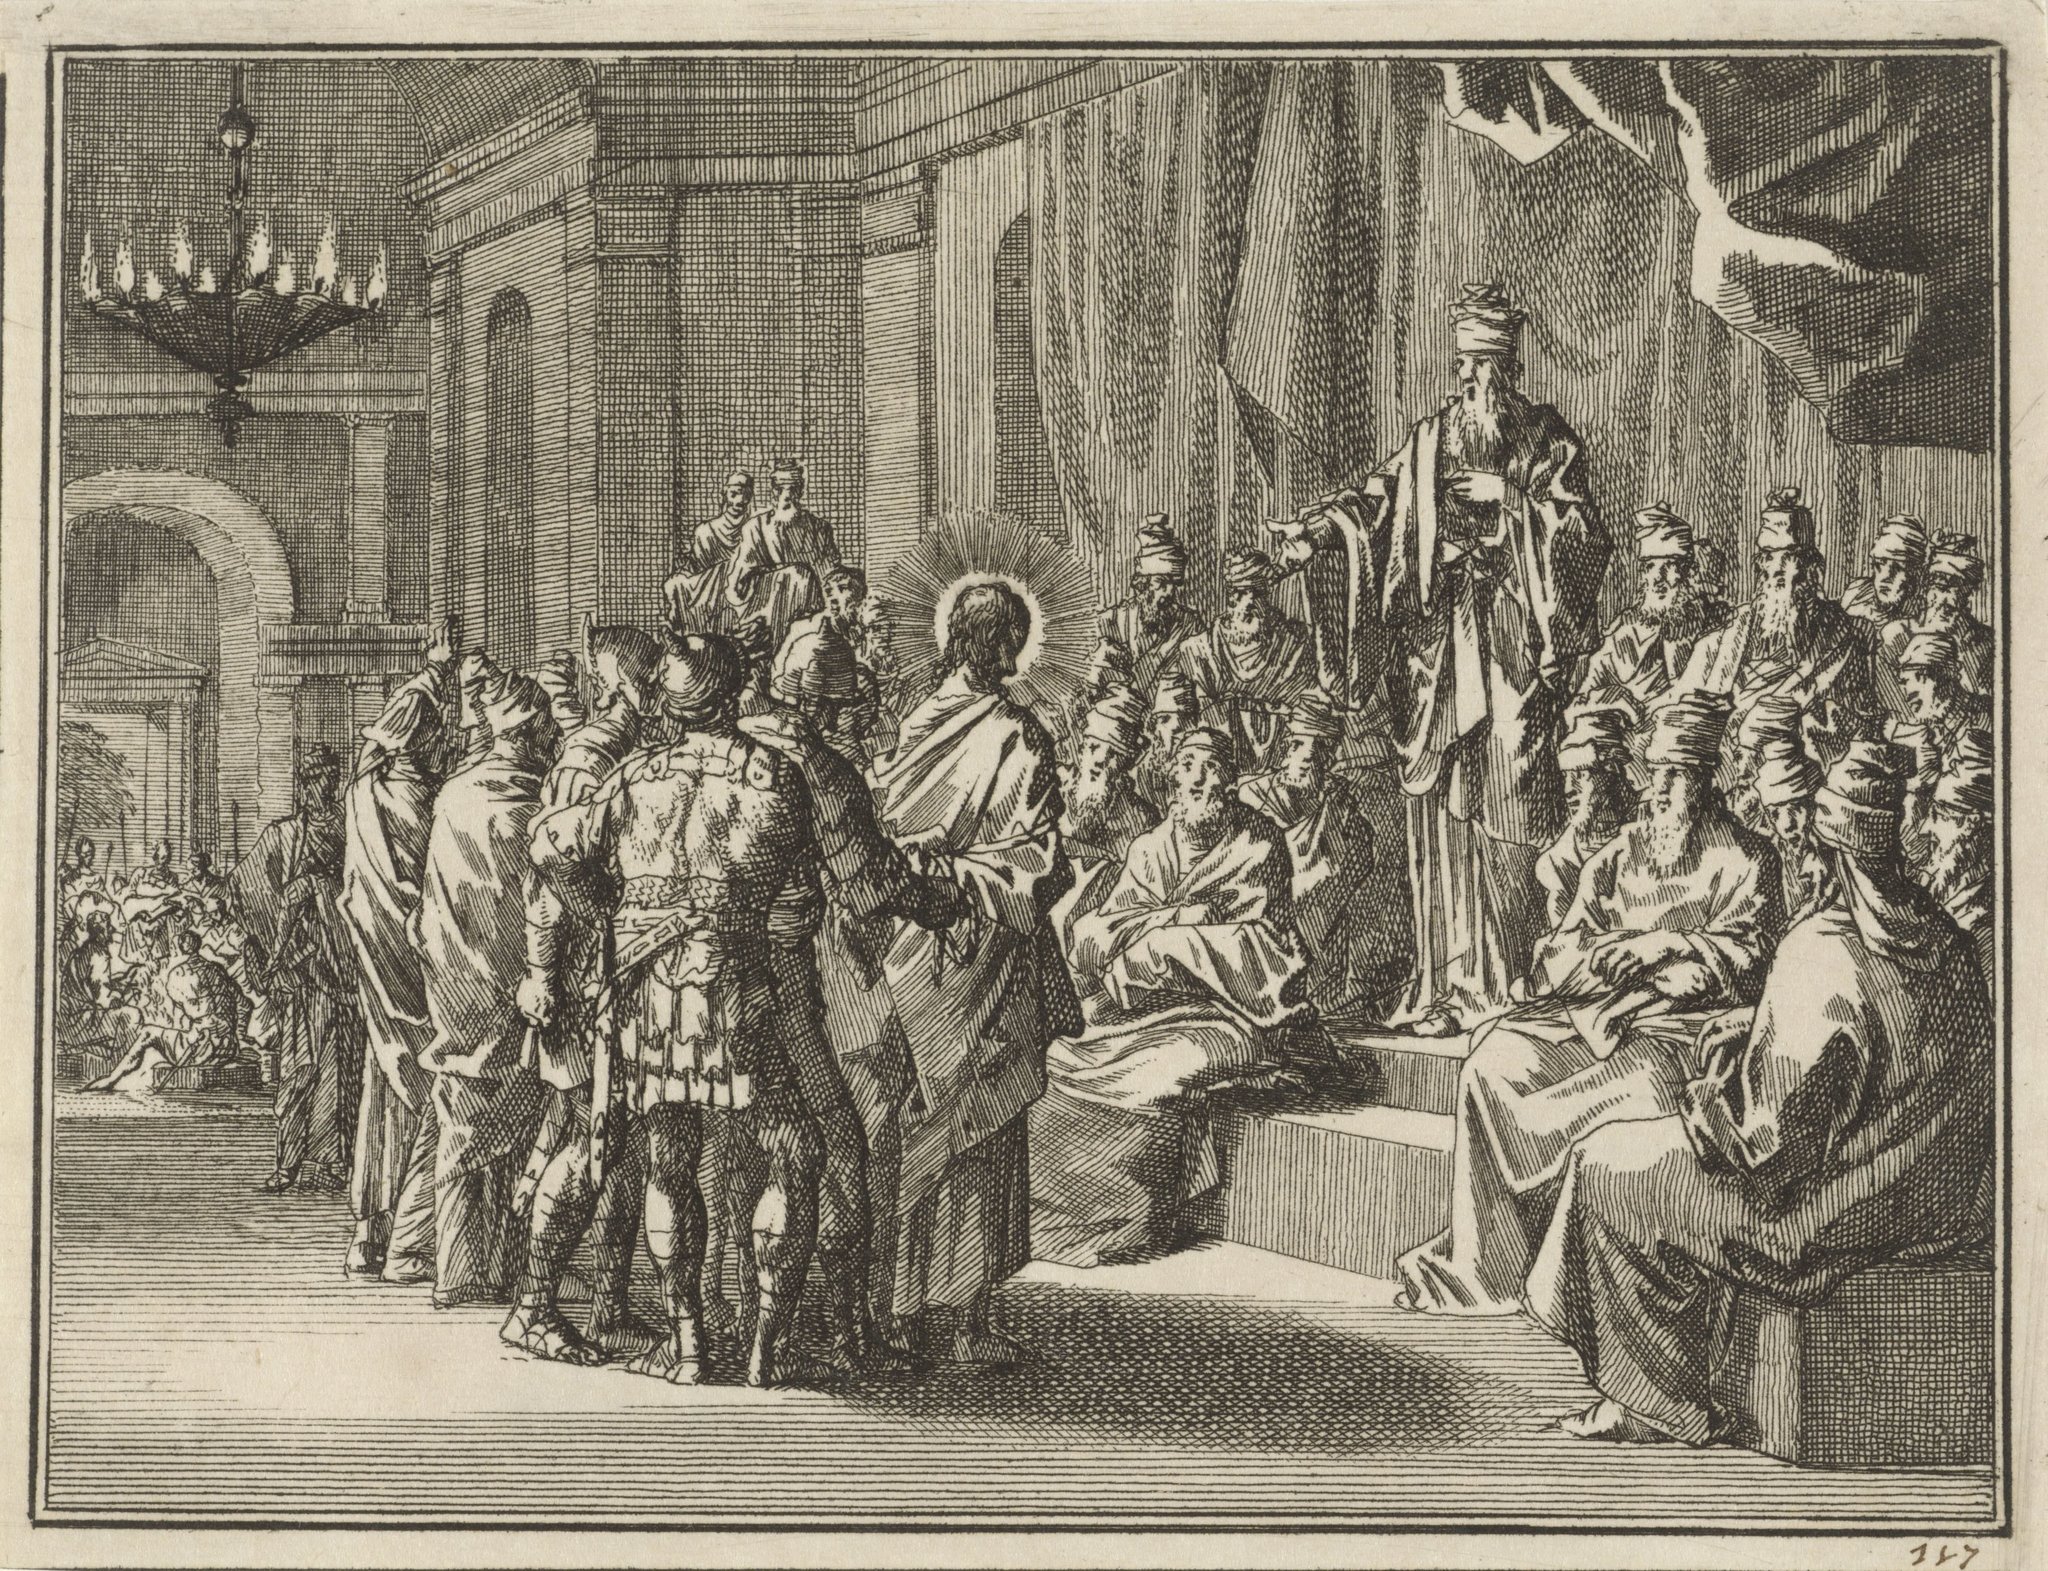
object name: print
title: Christus voor de hogepriester Annas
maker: jan luyken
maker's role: draughtsman, print maker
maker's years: 1649-1712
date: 1712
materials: paper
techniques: etching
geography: amsterdam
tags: christ before annas (hanna); maybe a soldier about to strike christ (john 18:13, 18:19-24)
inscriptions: collector's mark: Lugt 2228, number: ‘117’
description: Proefdruk van illustratie uit: Luyken, Jan. De schriftuurlyke geschiedenissen en gelykenissen van het Oude en Nieuwe Verbond, 2 delen. Amsterdam: Wed. Pieter Arentsz II en Cornelis van der Sys, 1712, dl. II.